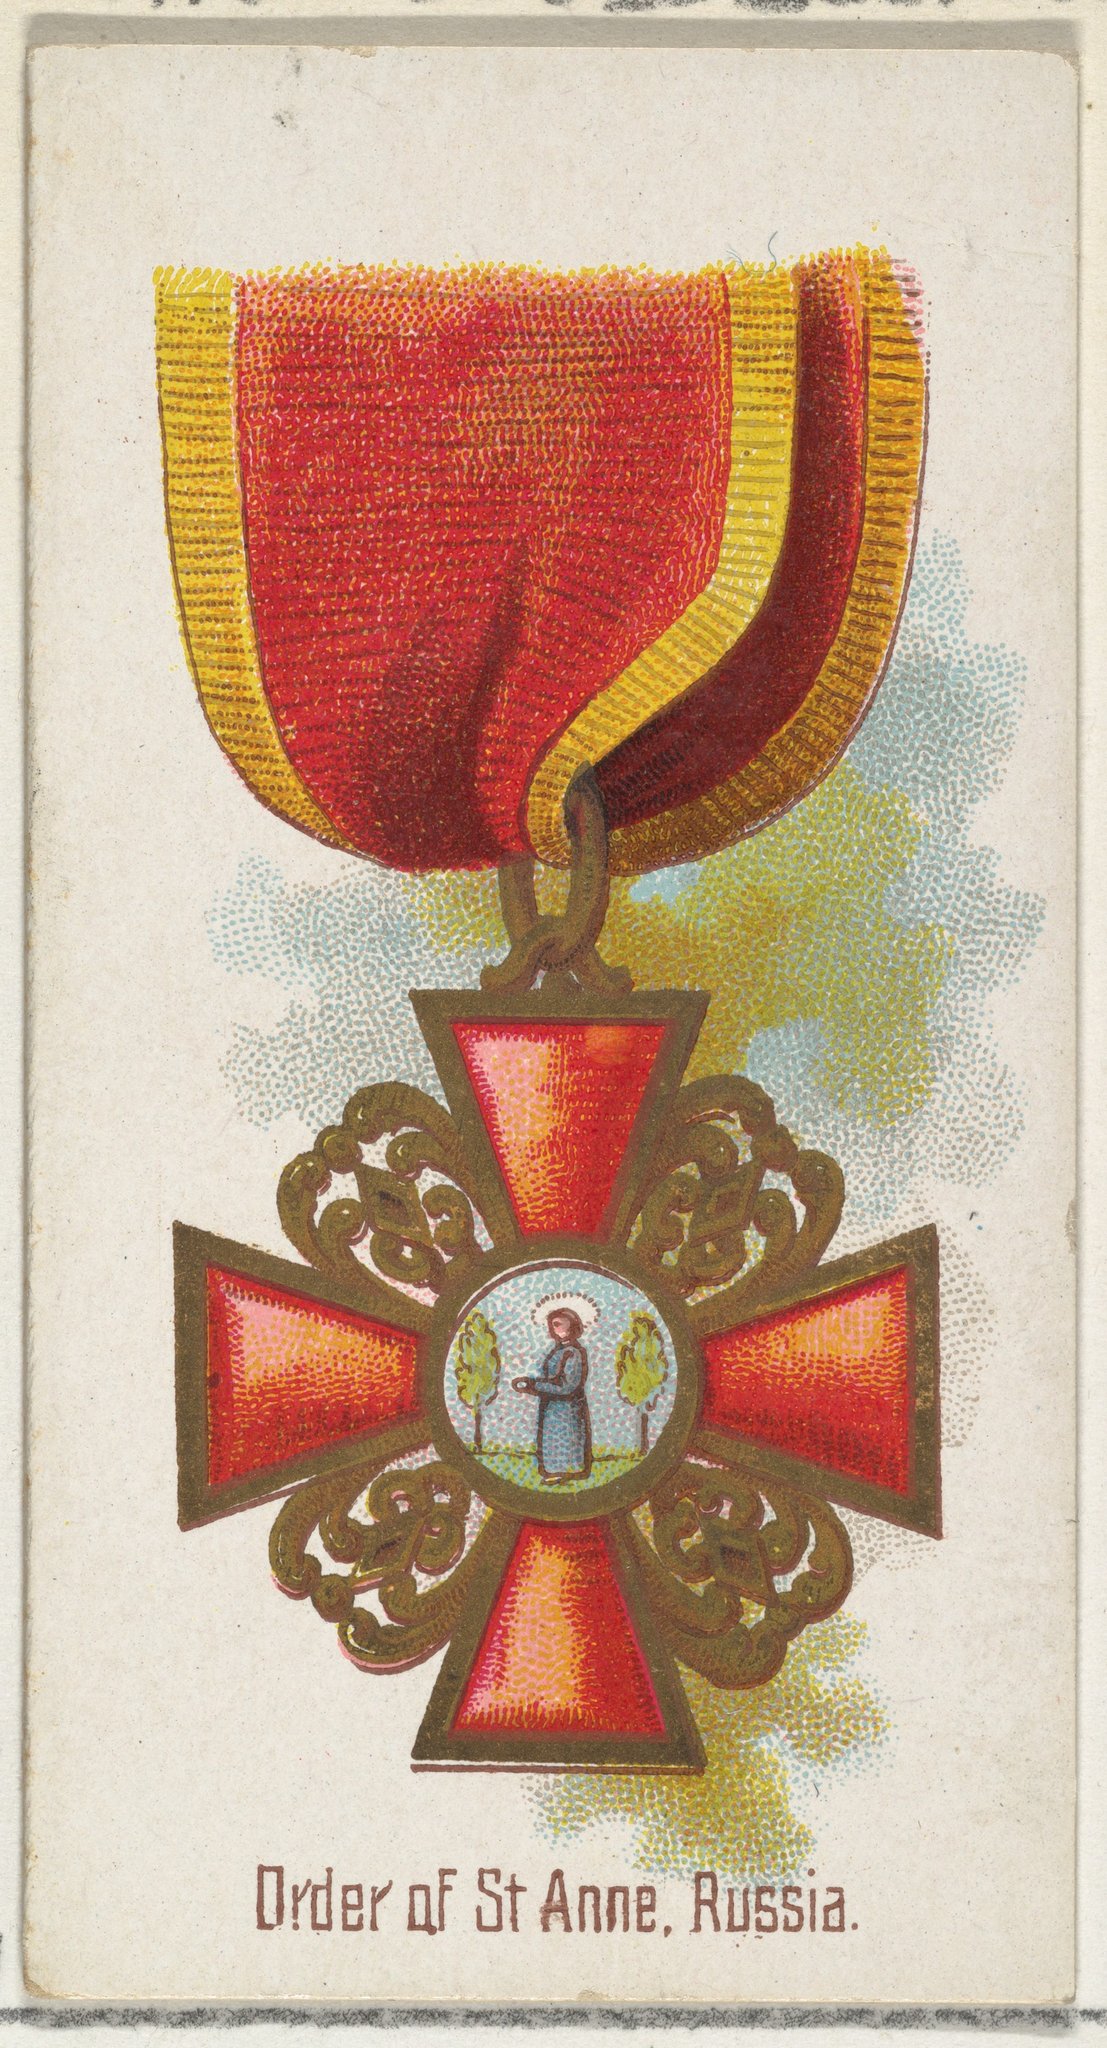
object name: print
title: Order of St. Anne, Russia, from the World's Decorations series (N30) for Allen & Ginter Cigarettes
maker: allen & ginter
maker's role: publisher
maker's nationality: american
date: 1890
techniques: color lithograph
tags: medals